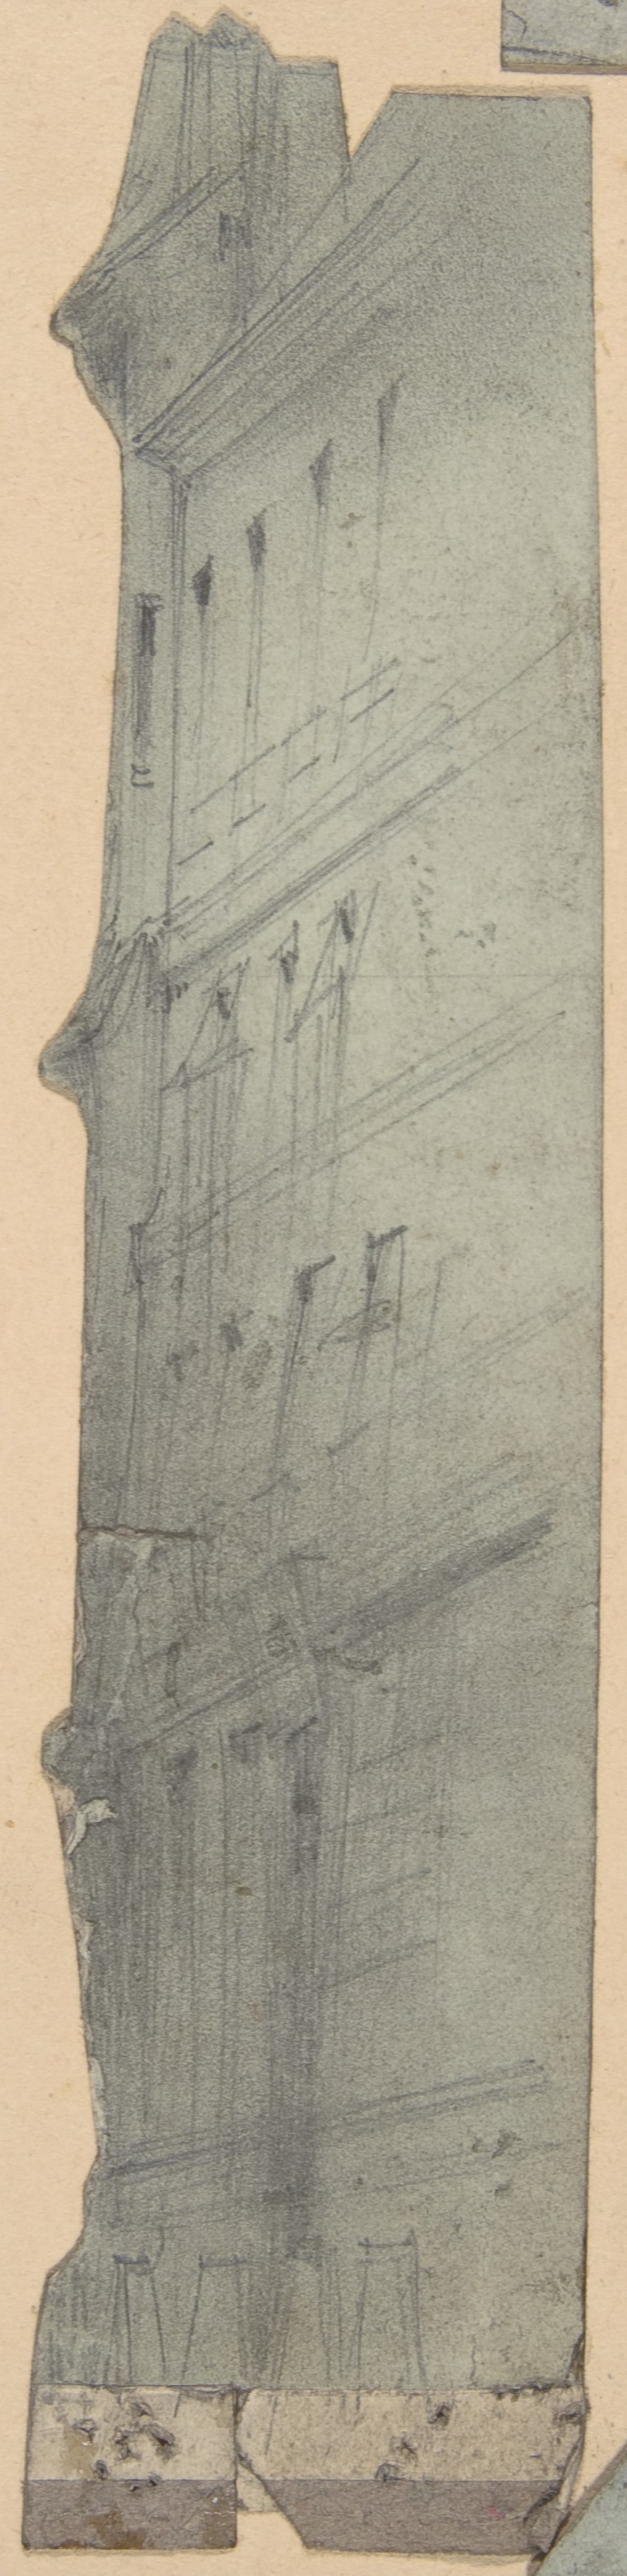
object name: drawing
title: Design for a Stage Set at the Opéra, Paris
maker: eugène cicéri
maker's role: artist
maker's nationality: french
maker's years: 1813-1890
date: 1830-1890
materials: graphite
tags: buildings,stage design